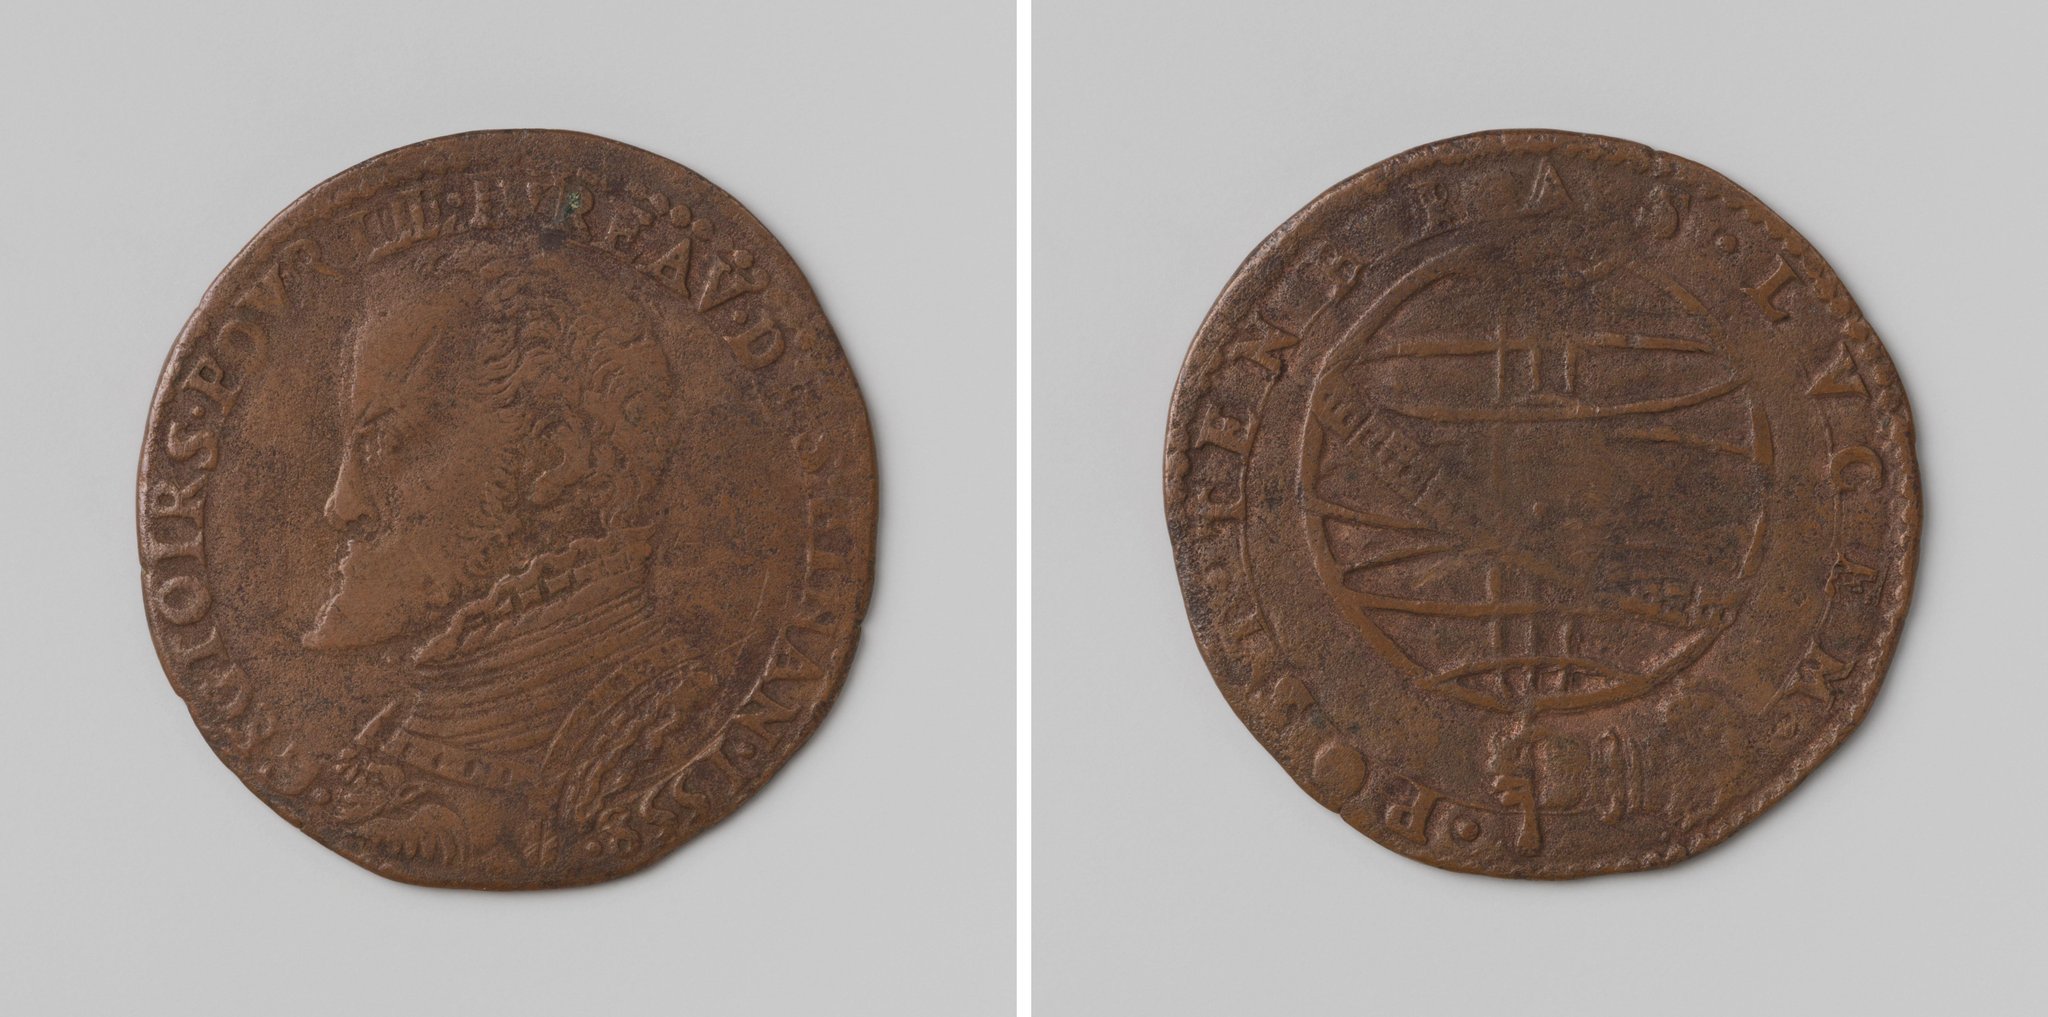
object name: jeton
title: Slag bij Grevelingen, ter ere van Filips II, koning van Spanje, rekenpenning van de raad van Financien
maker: Anonymous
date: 1558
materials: copper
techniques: striking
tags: philip ii of spain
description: Koperen penning. Voorzijde: borststuk man binnen omschrift. Keerzijde: aardbol, omgeven door hemelsferen, vastgehouden door hand binnen omschrift